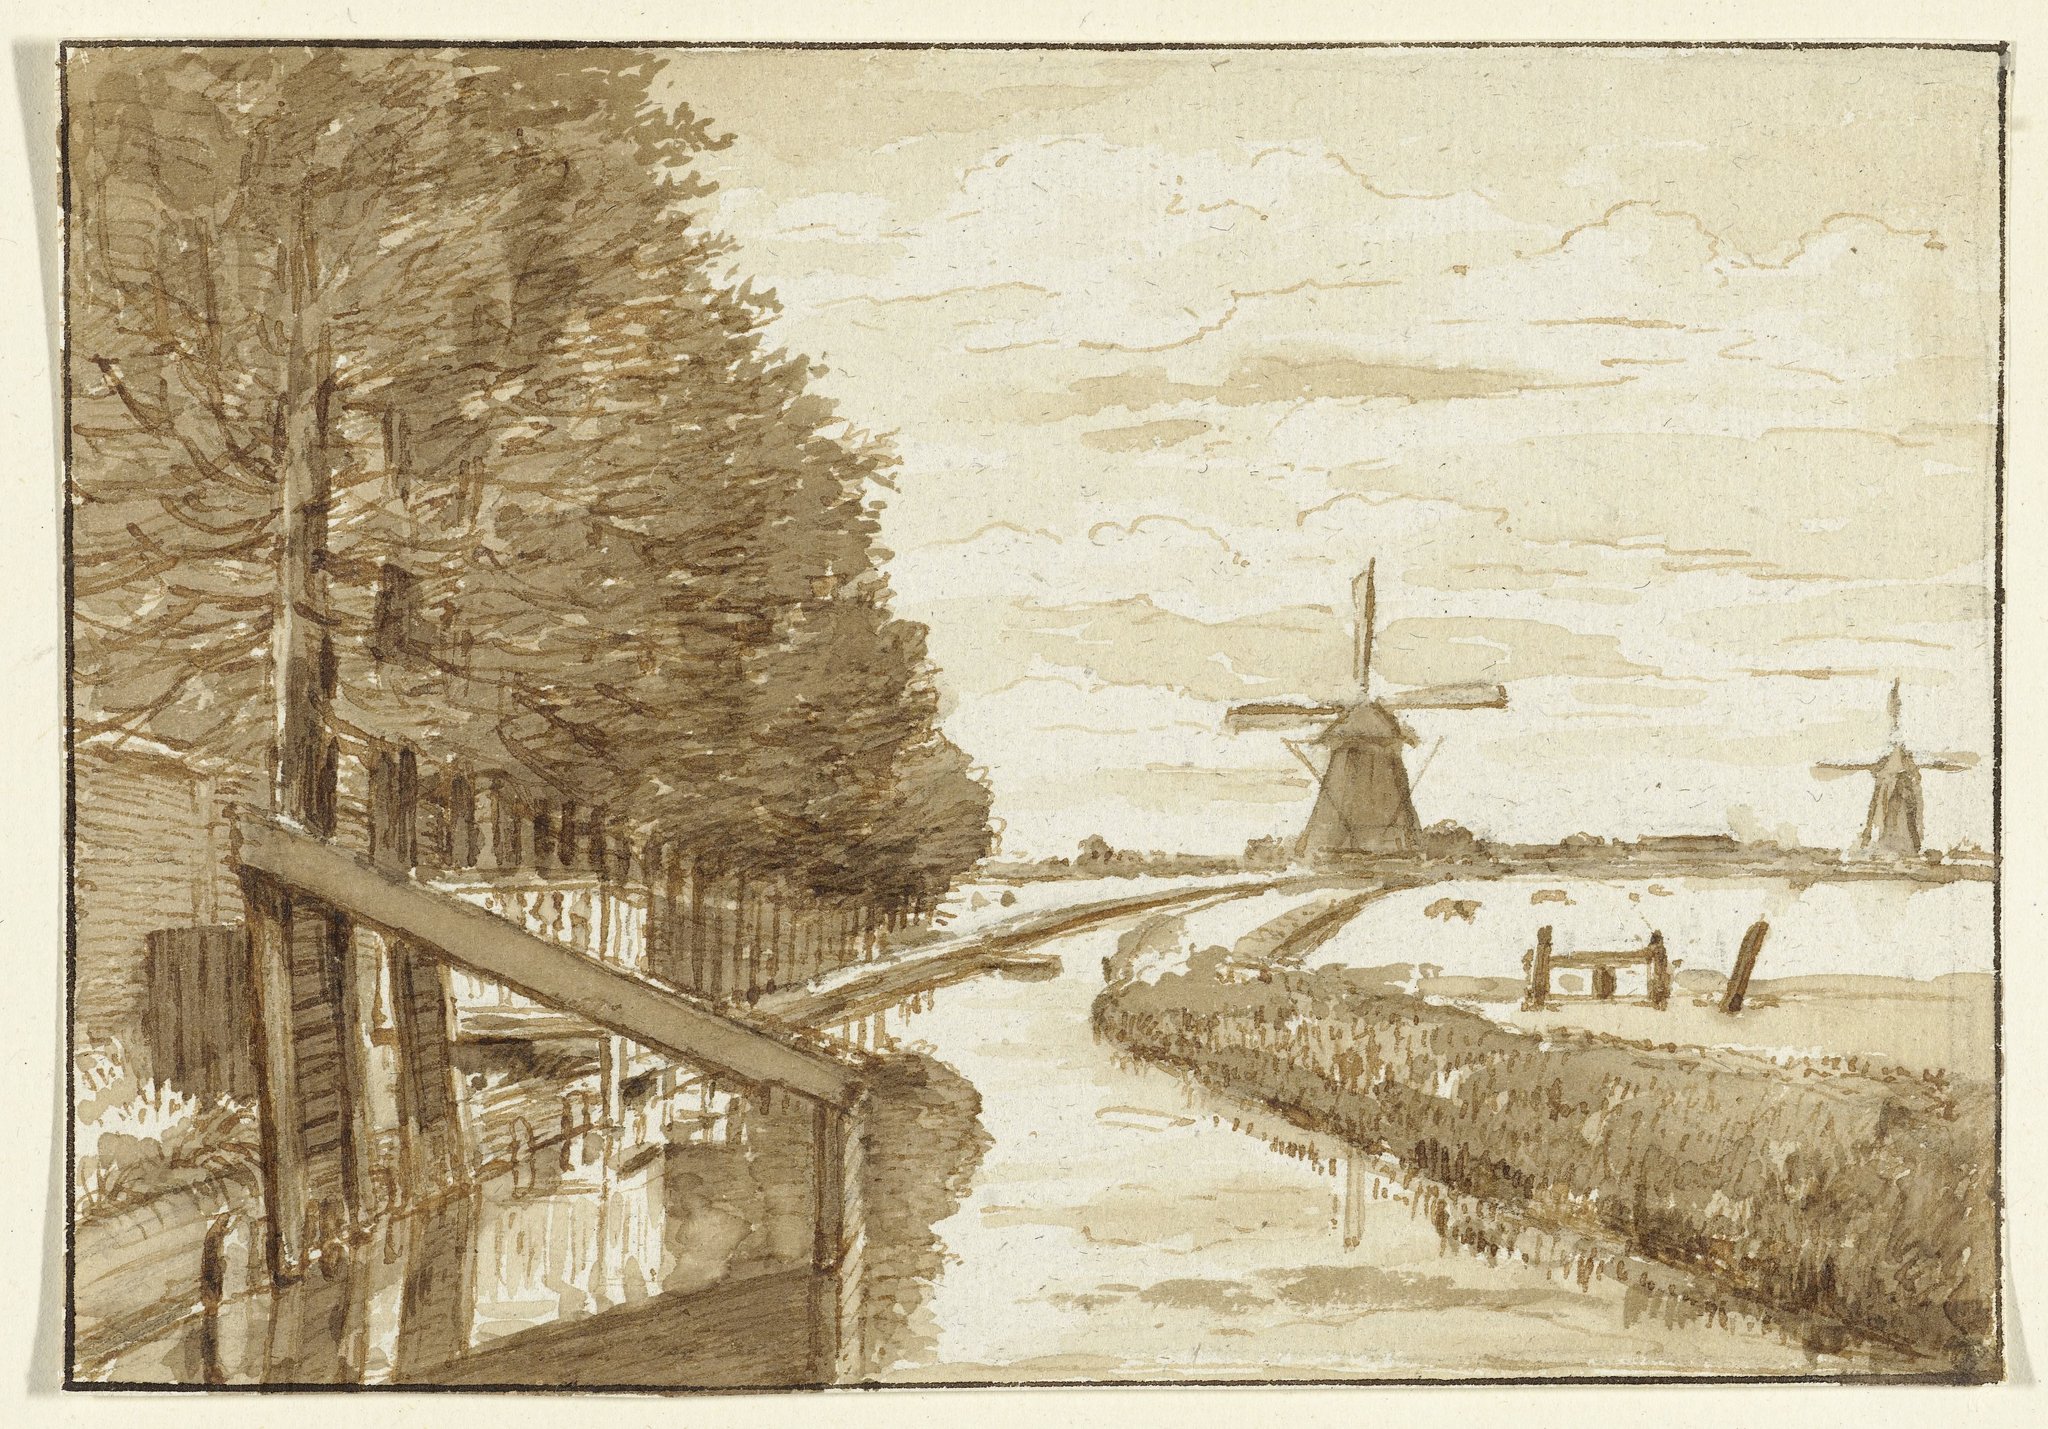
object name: drawing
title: Landschap met een vaart en twee molens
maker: jean bernard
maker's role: draughtsman, print maker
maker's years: 1765-1833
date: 1775-1833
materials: chalk, ink, paper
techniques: brush, pen